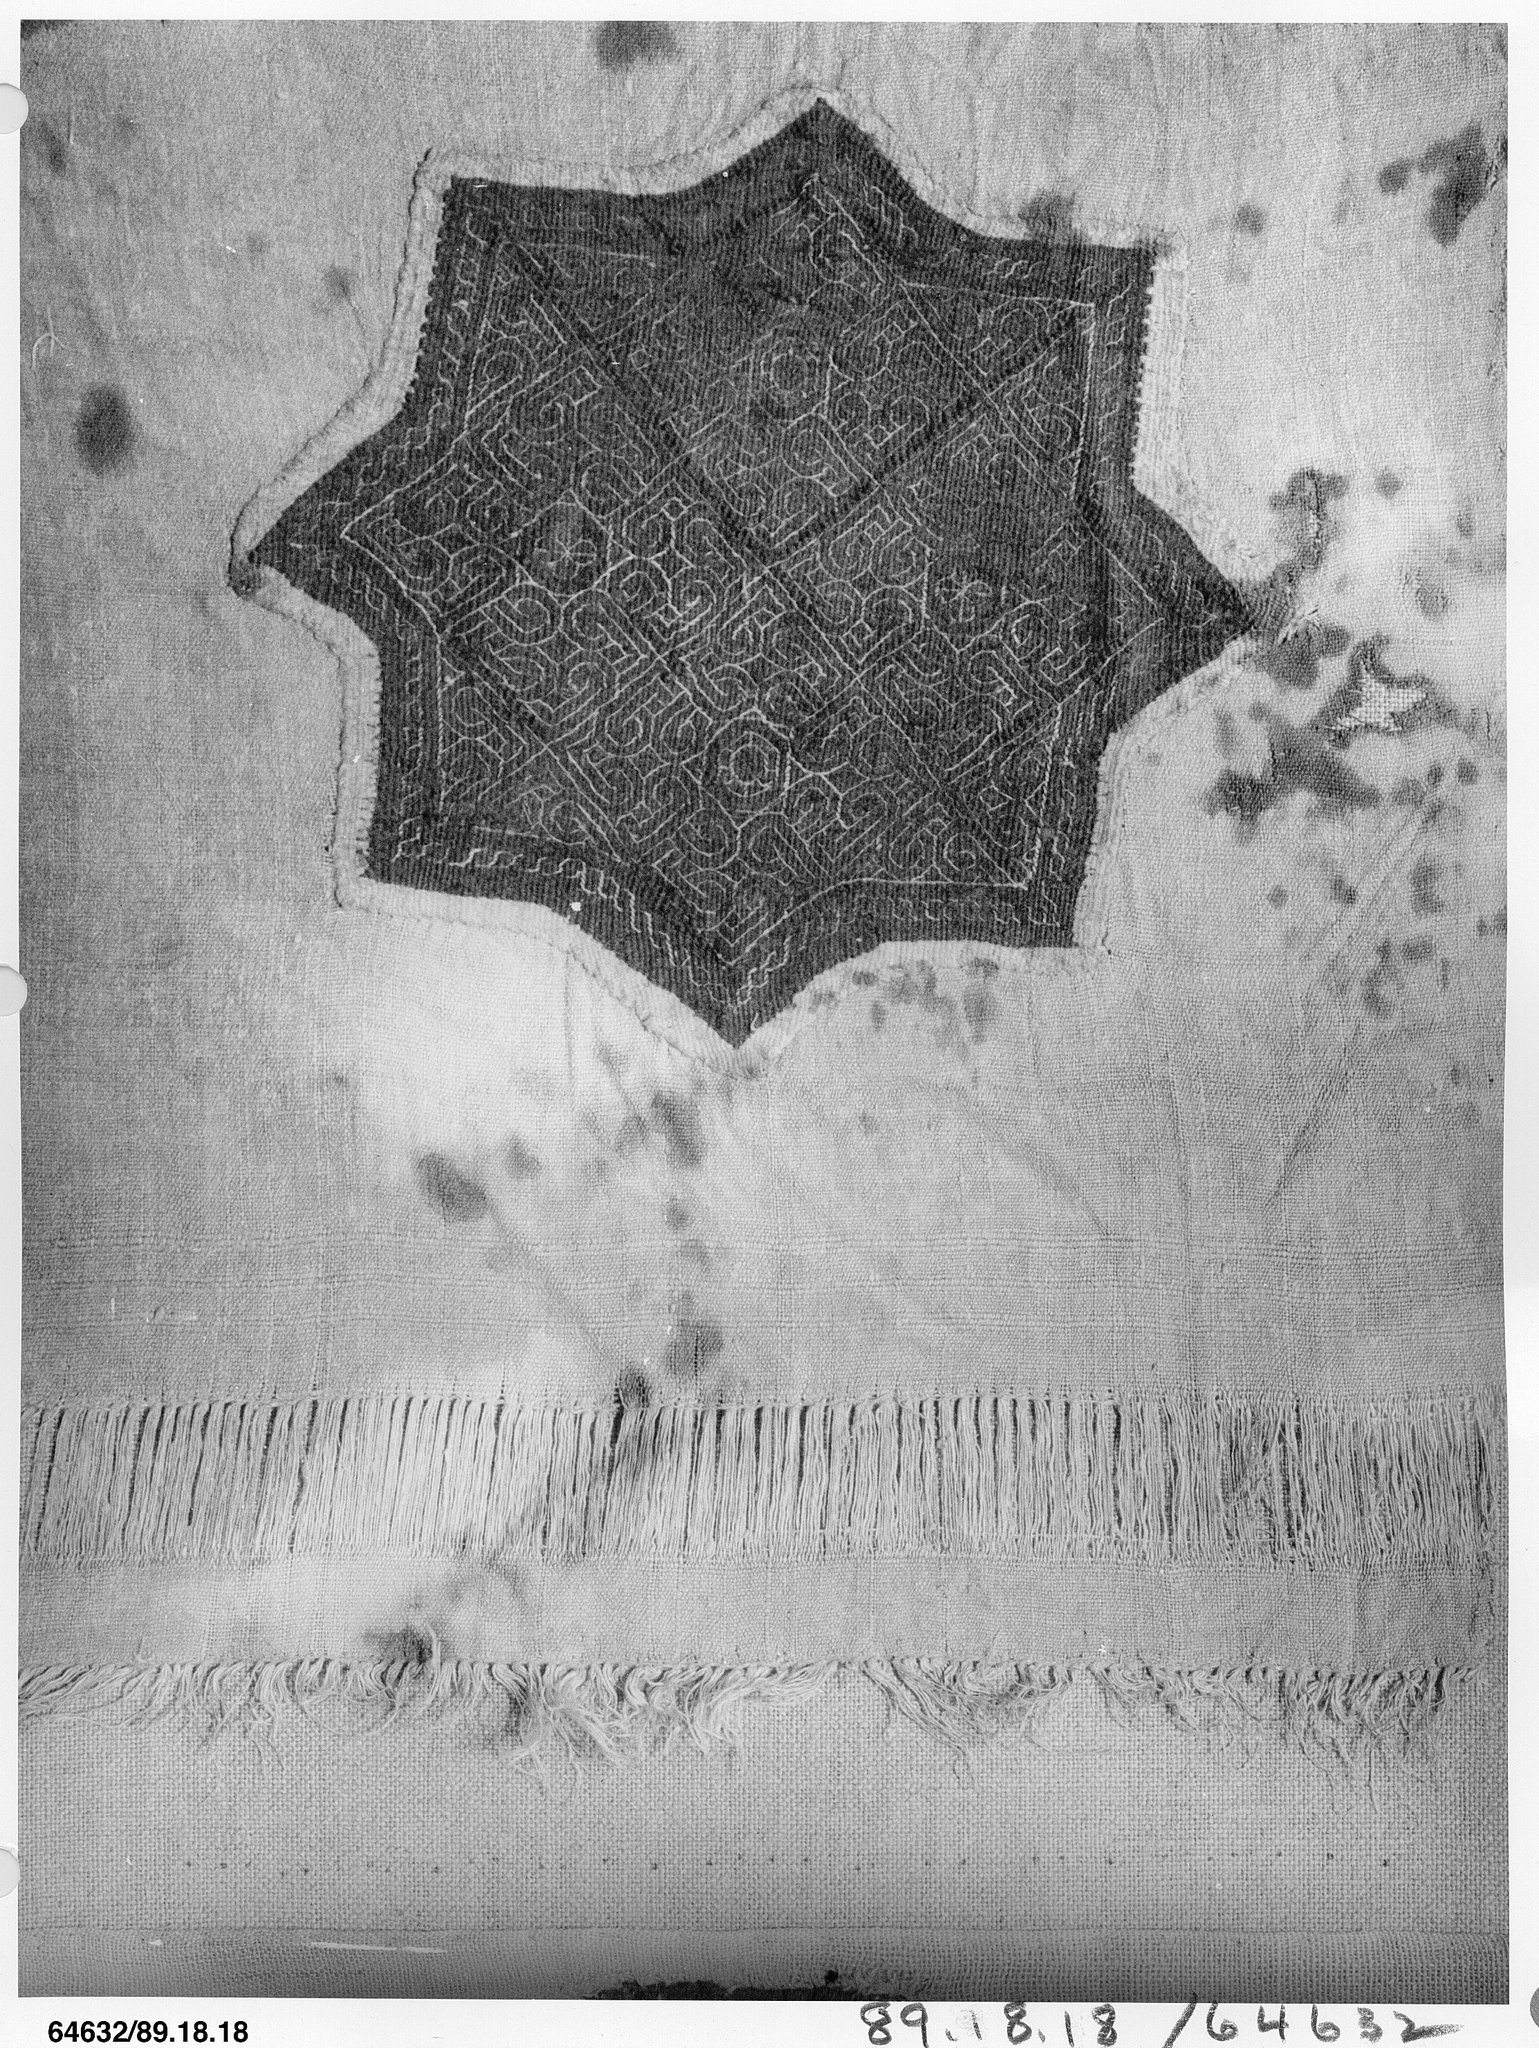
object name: textile fragment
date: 201-400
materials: linen, wool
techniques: weave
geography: egypt